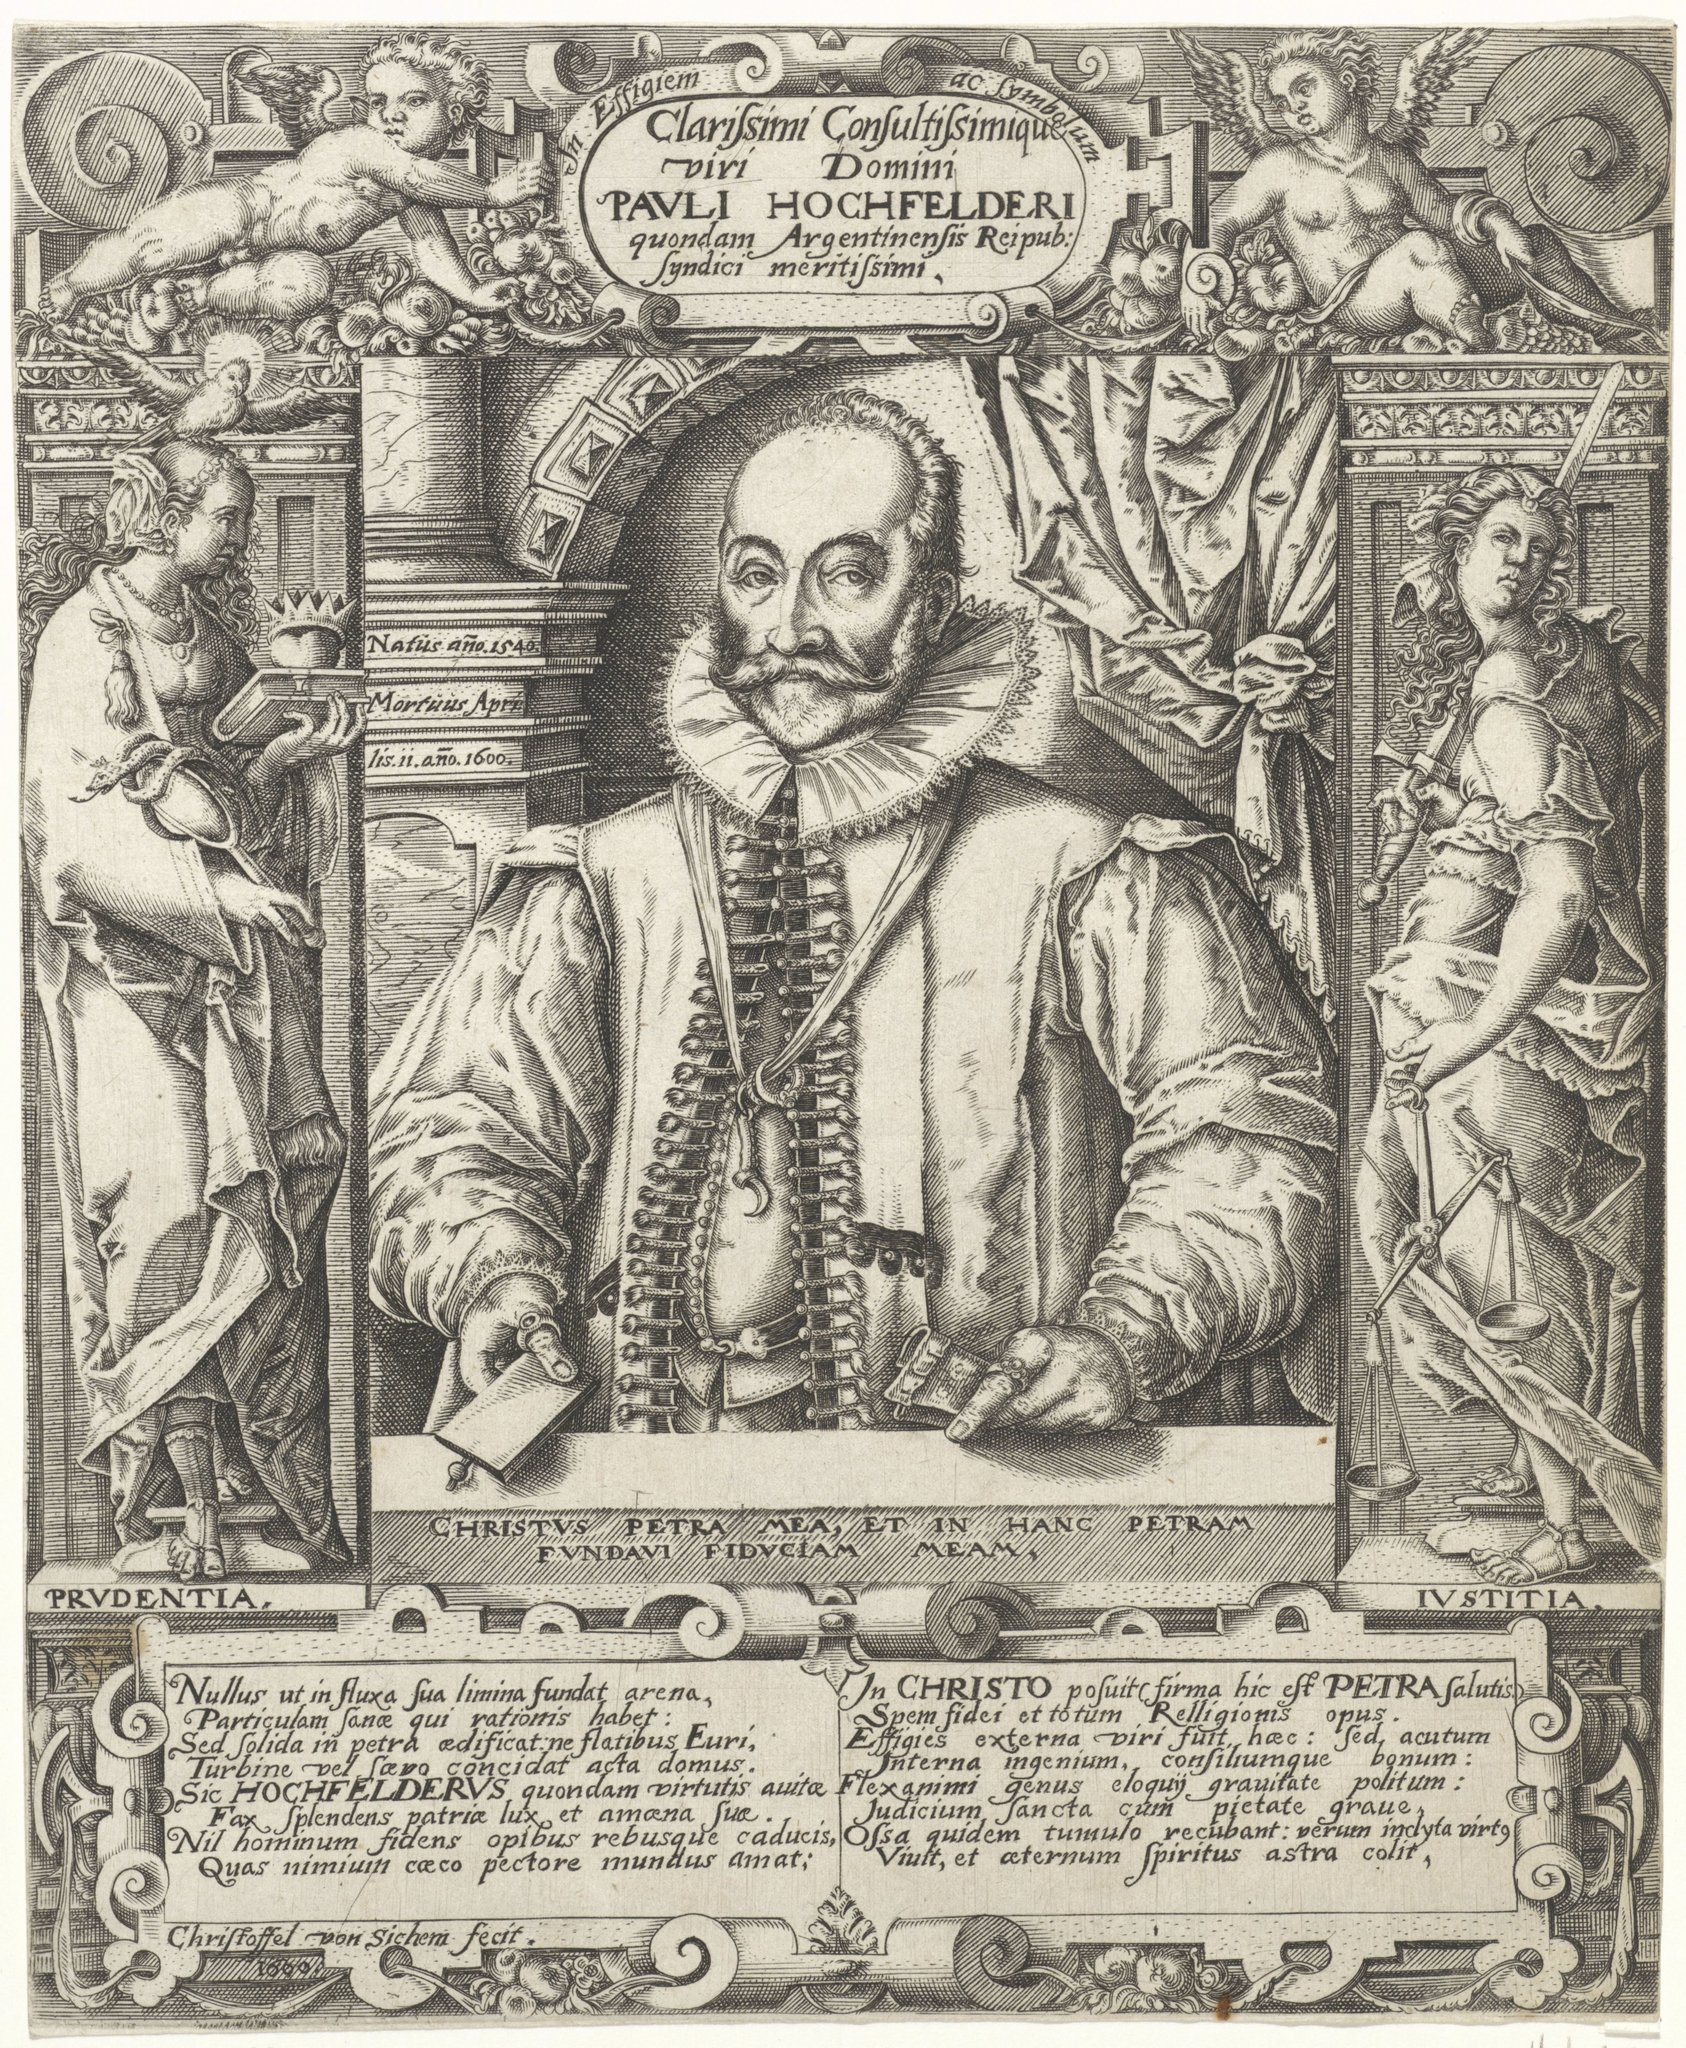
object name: print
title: Portret van Paul Hochfelder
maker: christoffel van sichem (i)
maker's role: print maker, publisher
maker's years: 1546-1624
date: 1600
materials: paper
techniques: engraving, etching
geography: basel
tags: syndicus, paul hochfelder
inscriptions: collector's mark: Lugt 2760, inscription: ‘HOCHFELDER, Paul, Syndicus i. Strasburg 1540-1600’, collector's mark: Lugt 2228, number: ‘N66st A(?)’, number: ‘D149.9086’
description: Portret van de Straatsburgse syndicus Paul Hochfelder, staand achter een balustrade, met in zijn hand een klein boekje. Hij wordt geflankeerd door Justitia en Prudentia. Boven zijn hoofd twee putti met cartouche waarin zijn naam en functie. Op de zuil achter hem zijn geboorte- en sterfdatum. Latijnse tekst onderaan in cartouche met rolwerk.